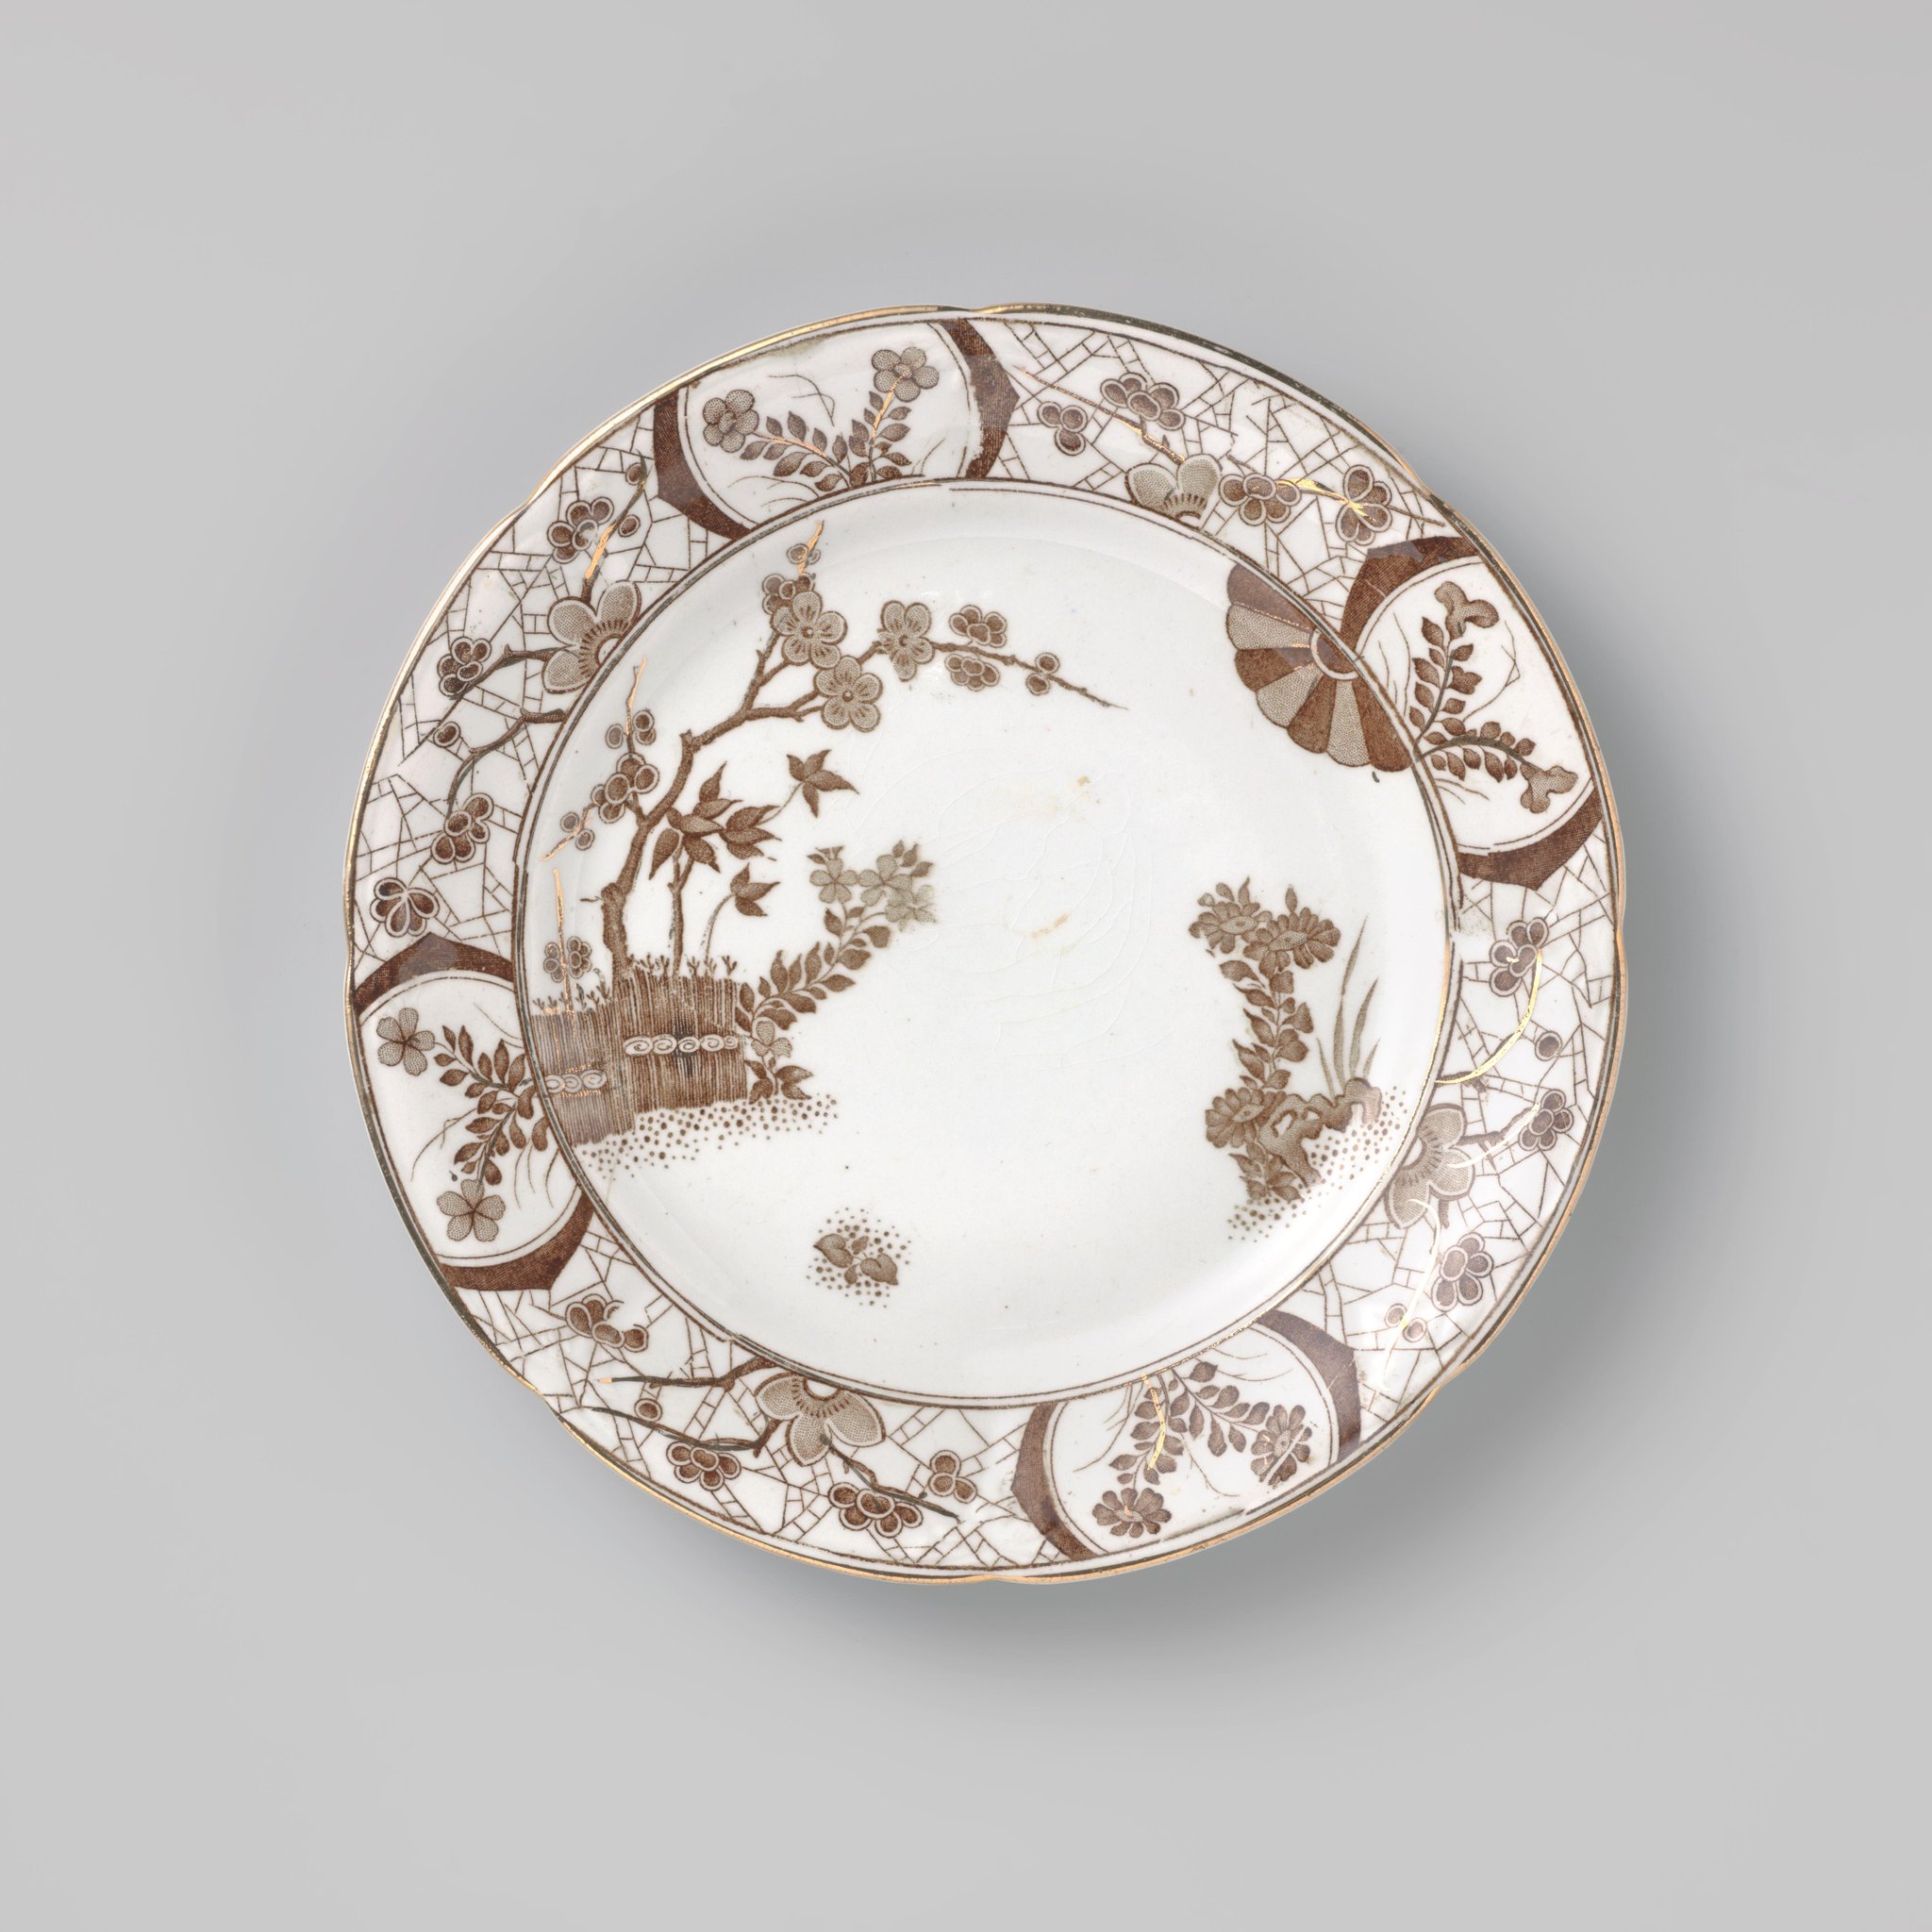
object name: plate dish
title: Bord met op het plat een bloemtak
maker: petrus regout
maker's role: plateelbakker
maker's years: 1801-1879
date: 1900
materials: earthenware, glaze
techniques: vitrification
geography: maastricht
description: Bord van aardewerk met bruin transferdecor, met moffelkleuren en okerluster. Op het plat een voorstelling van een bloemtak. Op de rand van het bord broken ice.